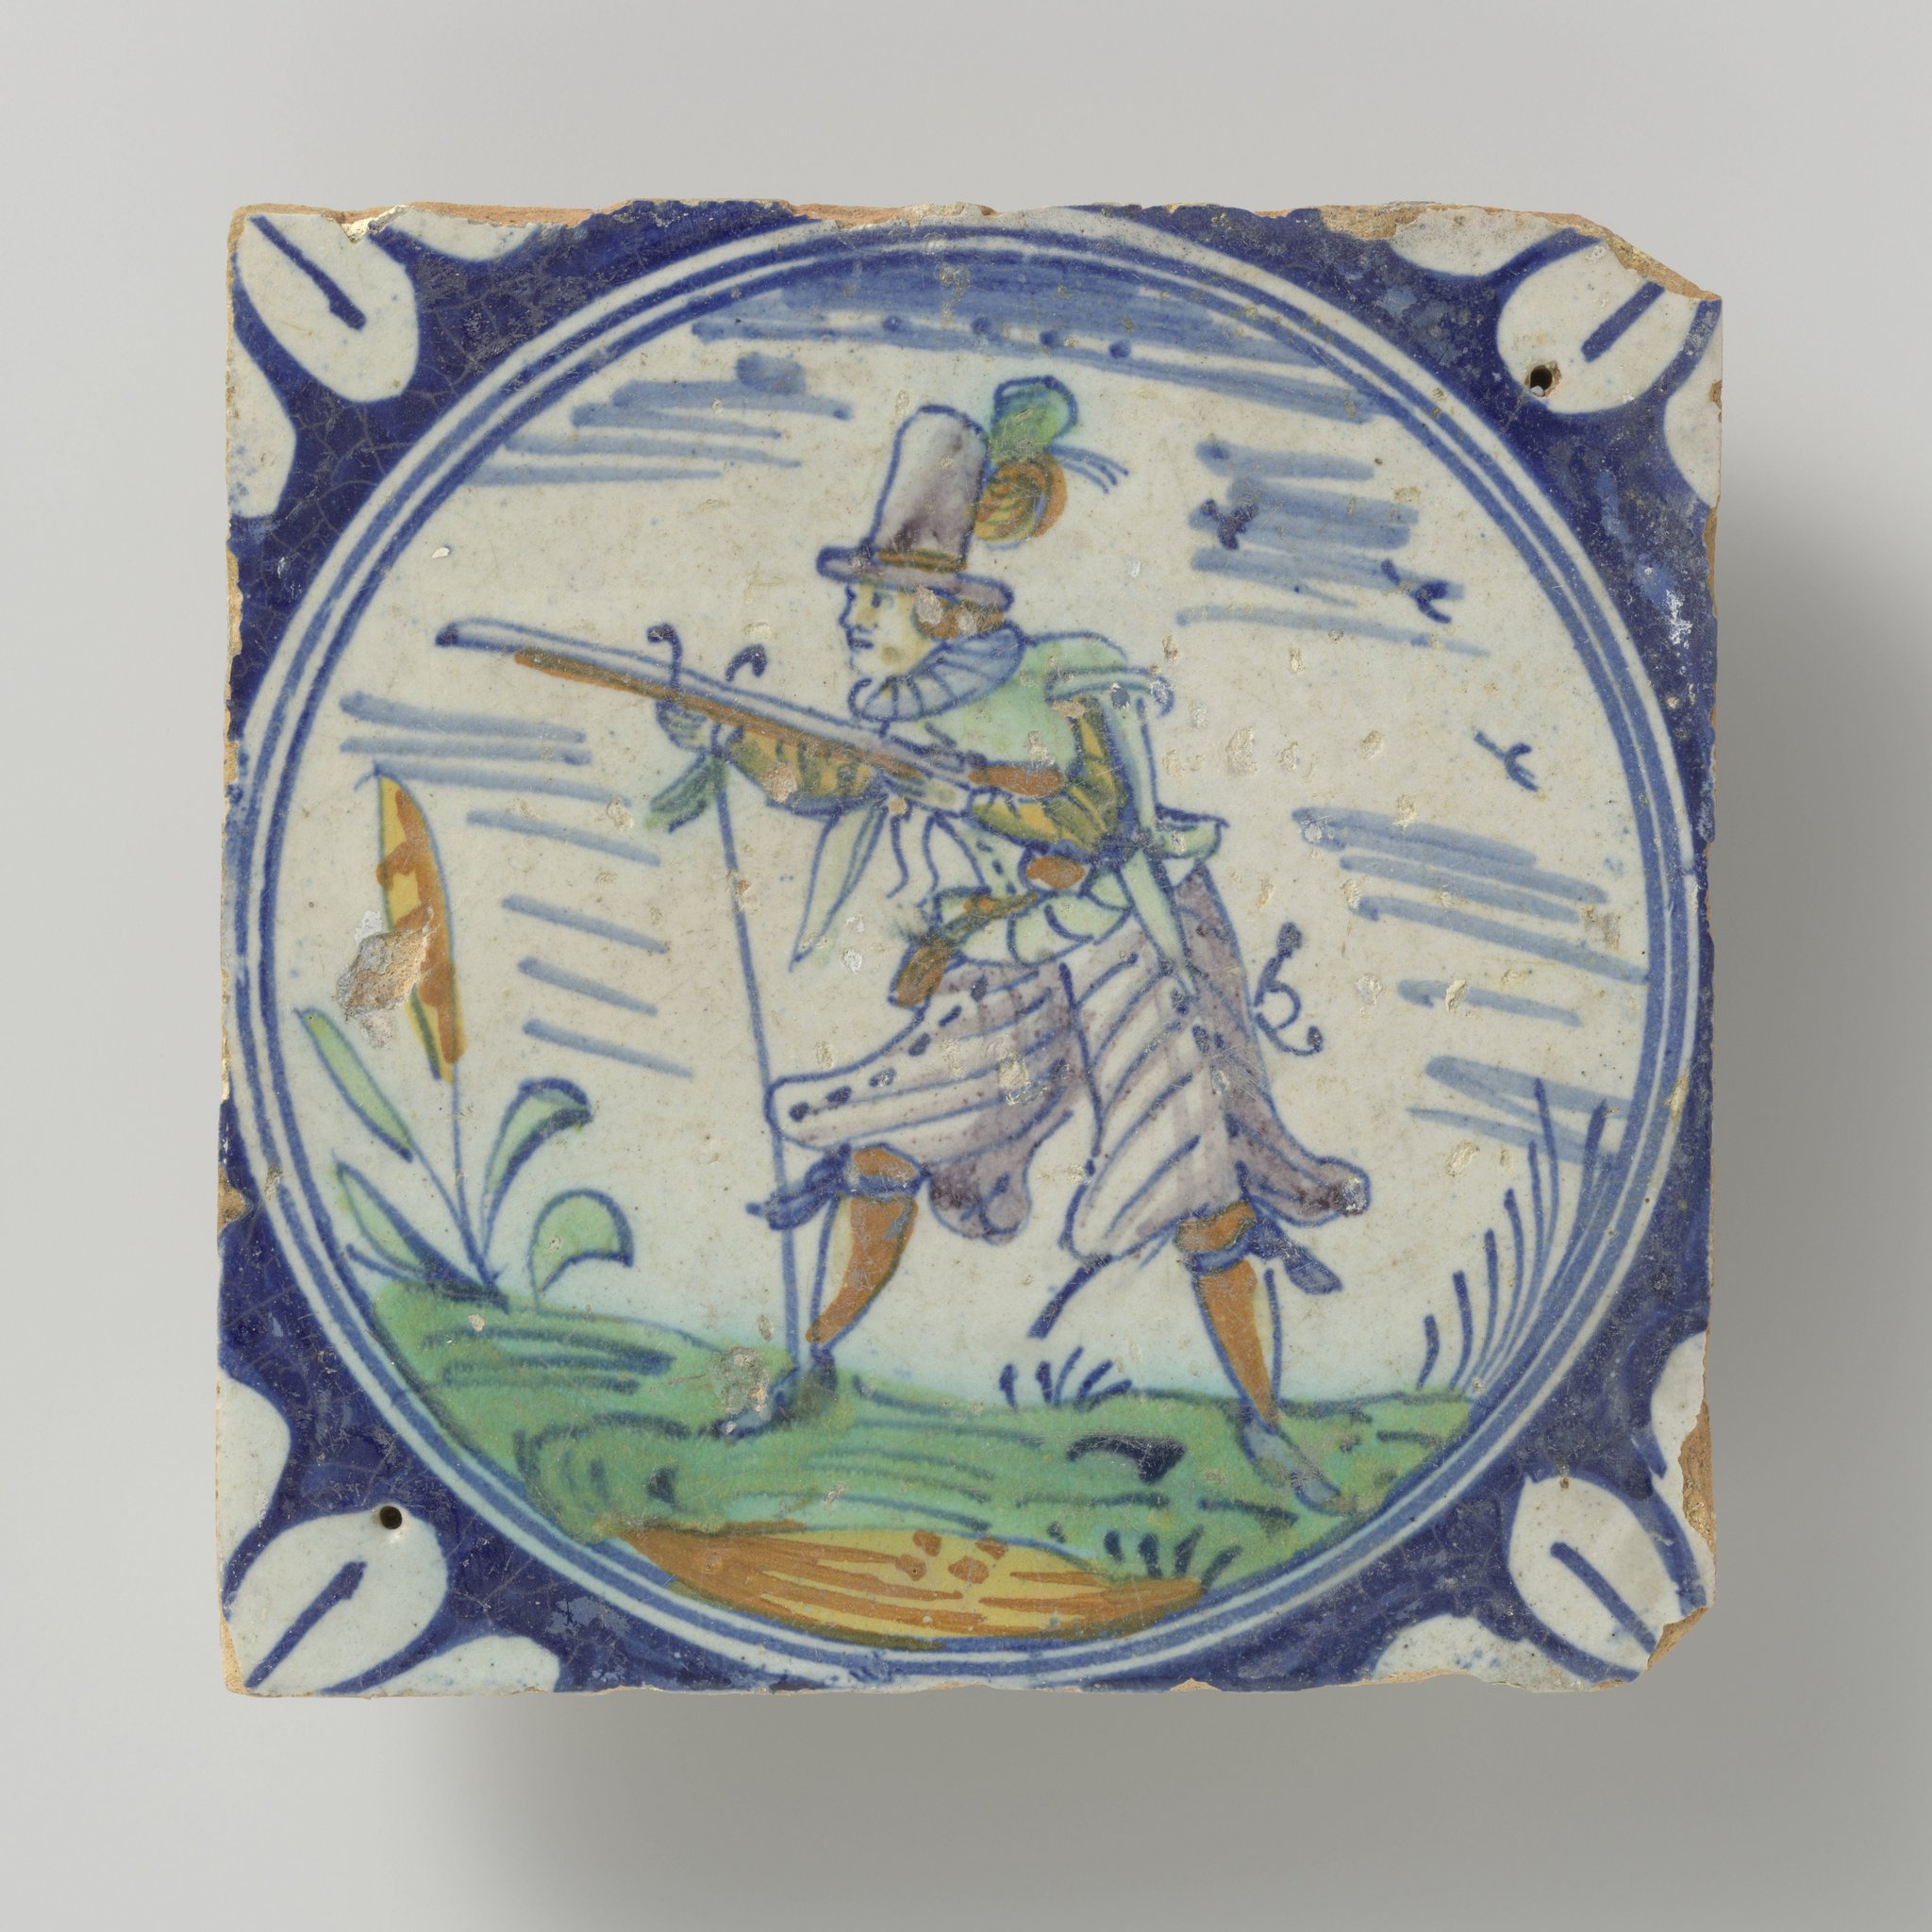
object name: tile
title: Tegel, veelkleurig beschilderd met een soldaat of een vaandeldrager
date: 1625-1700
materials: earthenware, glaze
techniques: maiolica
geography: netherlands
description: Tegel, veelkleurig beschilderd met een soldaat of een vaandeldrager.